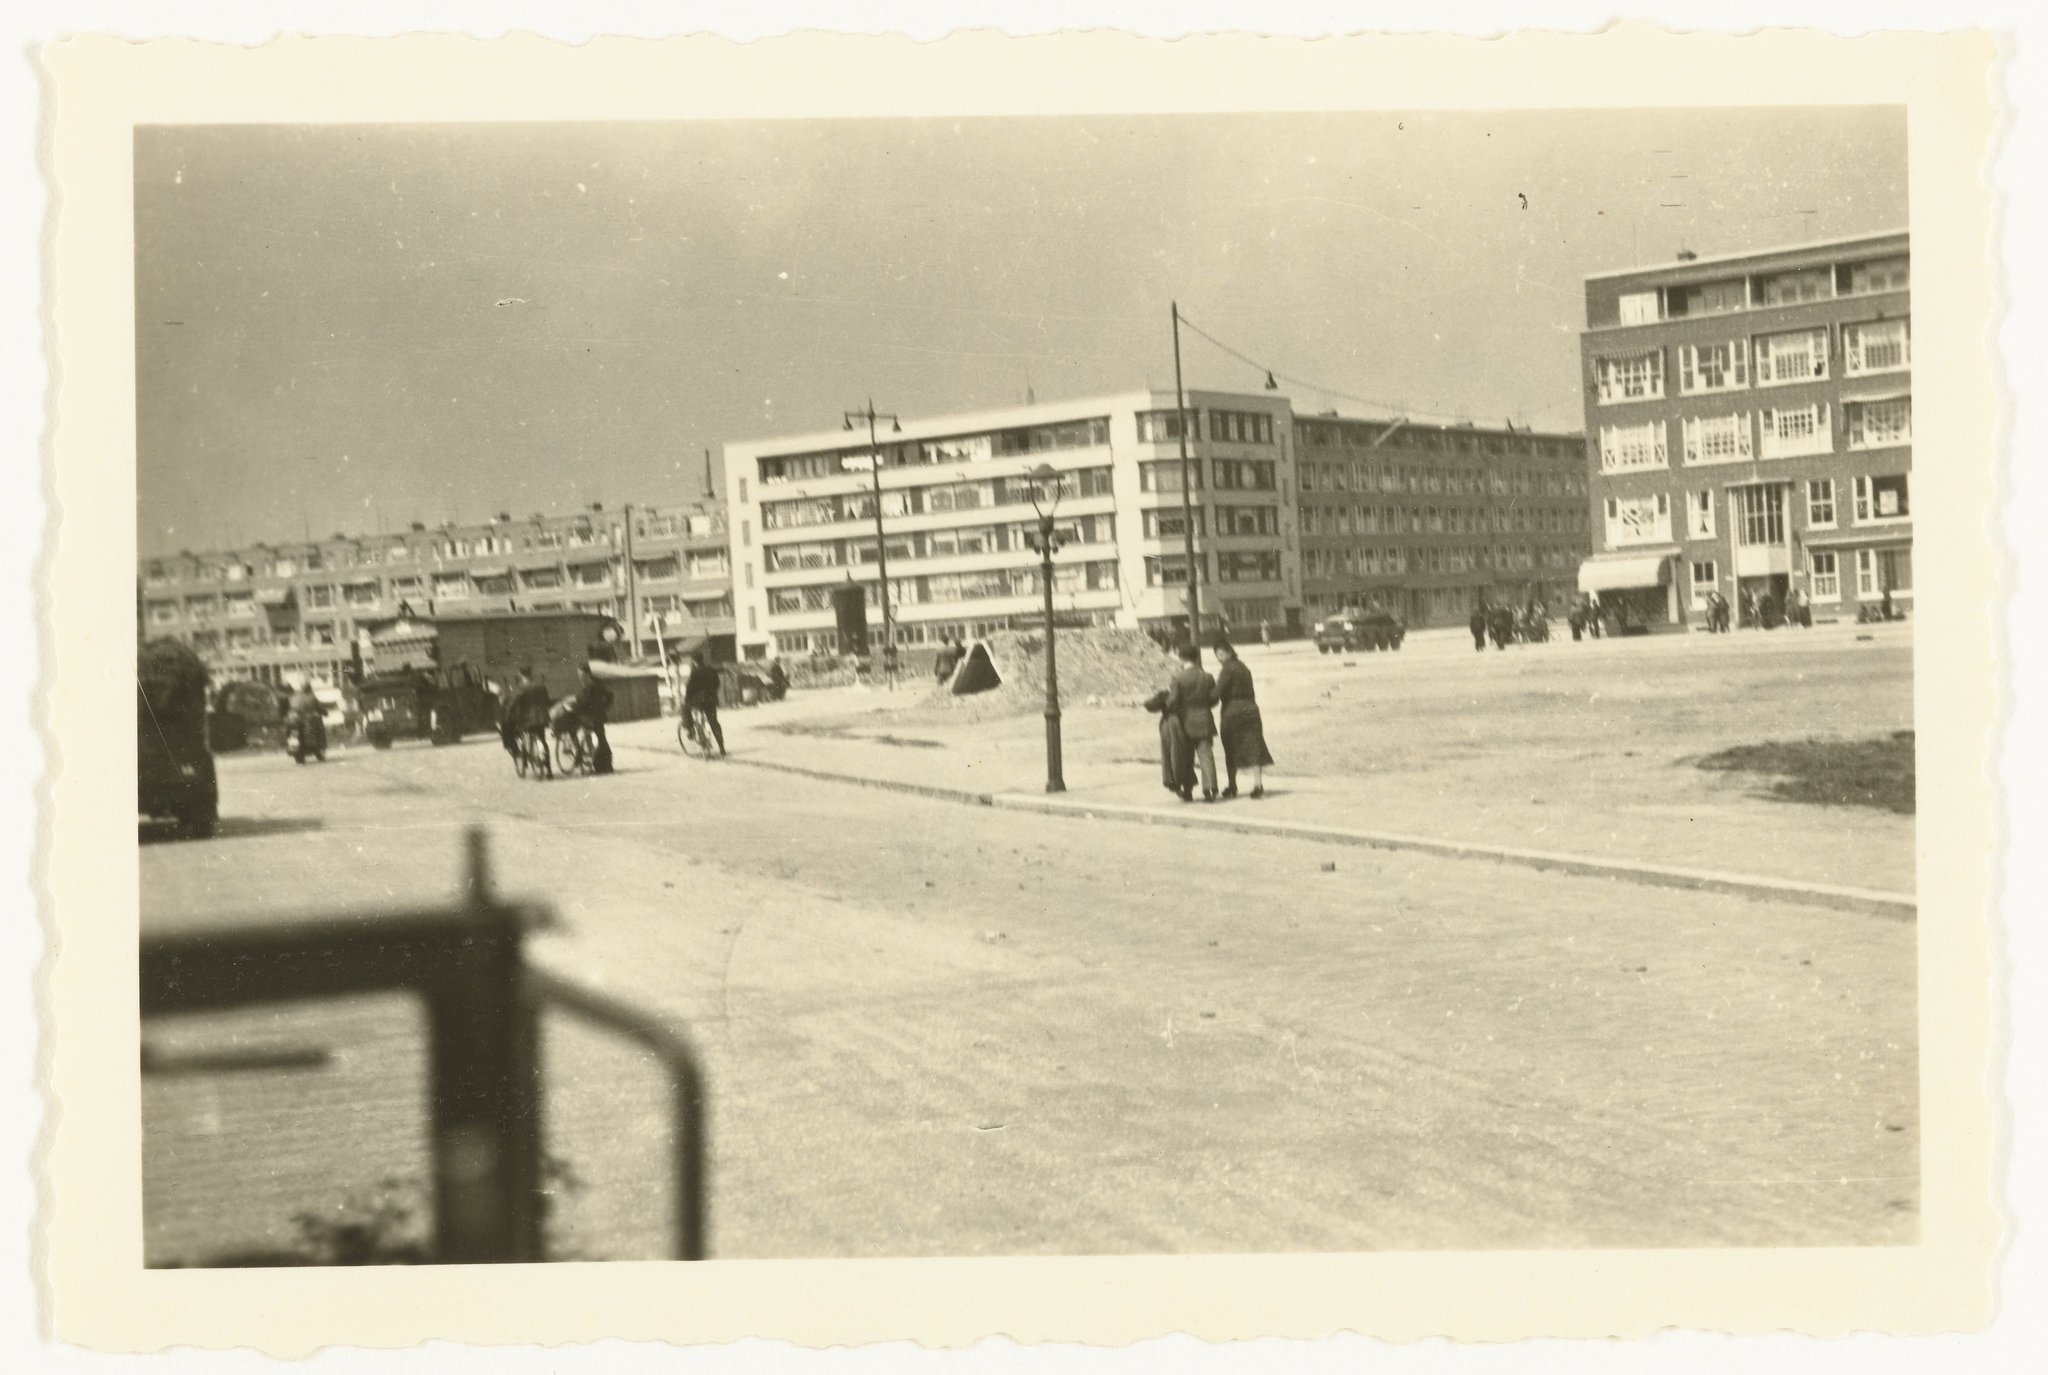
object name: photograph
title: Duitsers trekken Rotterdam binnen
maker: Anonymous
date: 1940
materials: photographic support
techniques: gelatin silver print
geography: rotterdam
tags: troop movements, transportation, march into the conquered place, rotterdam, rotterdam blitz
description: Duitsers trekken Rotterdam binnen. Op de foto zijn alleen een paar Duitse soldaten op de achtergrond te zien, verder een lege straat, wat flatgebouwen en een paar voetgangers en fietsers. Het is een zonnige dag, boven de huizen is een donkere lucht te zien. Als Rotterdam al gebombardeerd is moet deze foto na 13.20 gemaakt zijn, toen begon de aanval. Op de achterzijde staat: Rotterdam, Einfahrt, 14-5-40